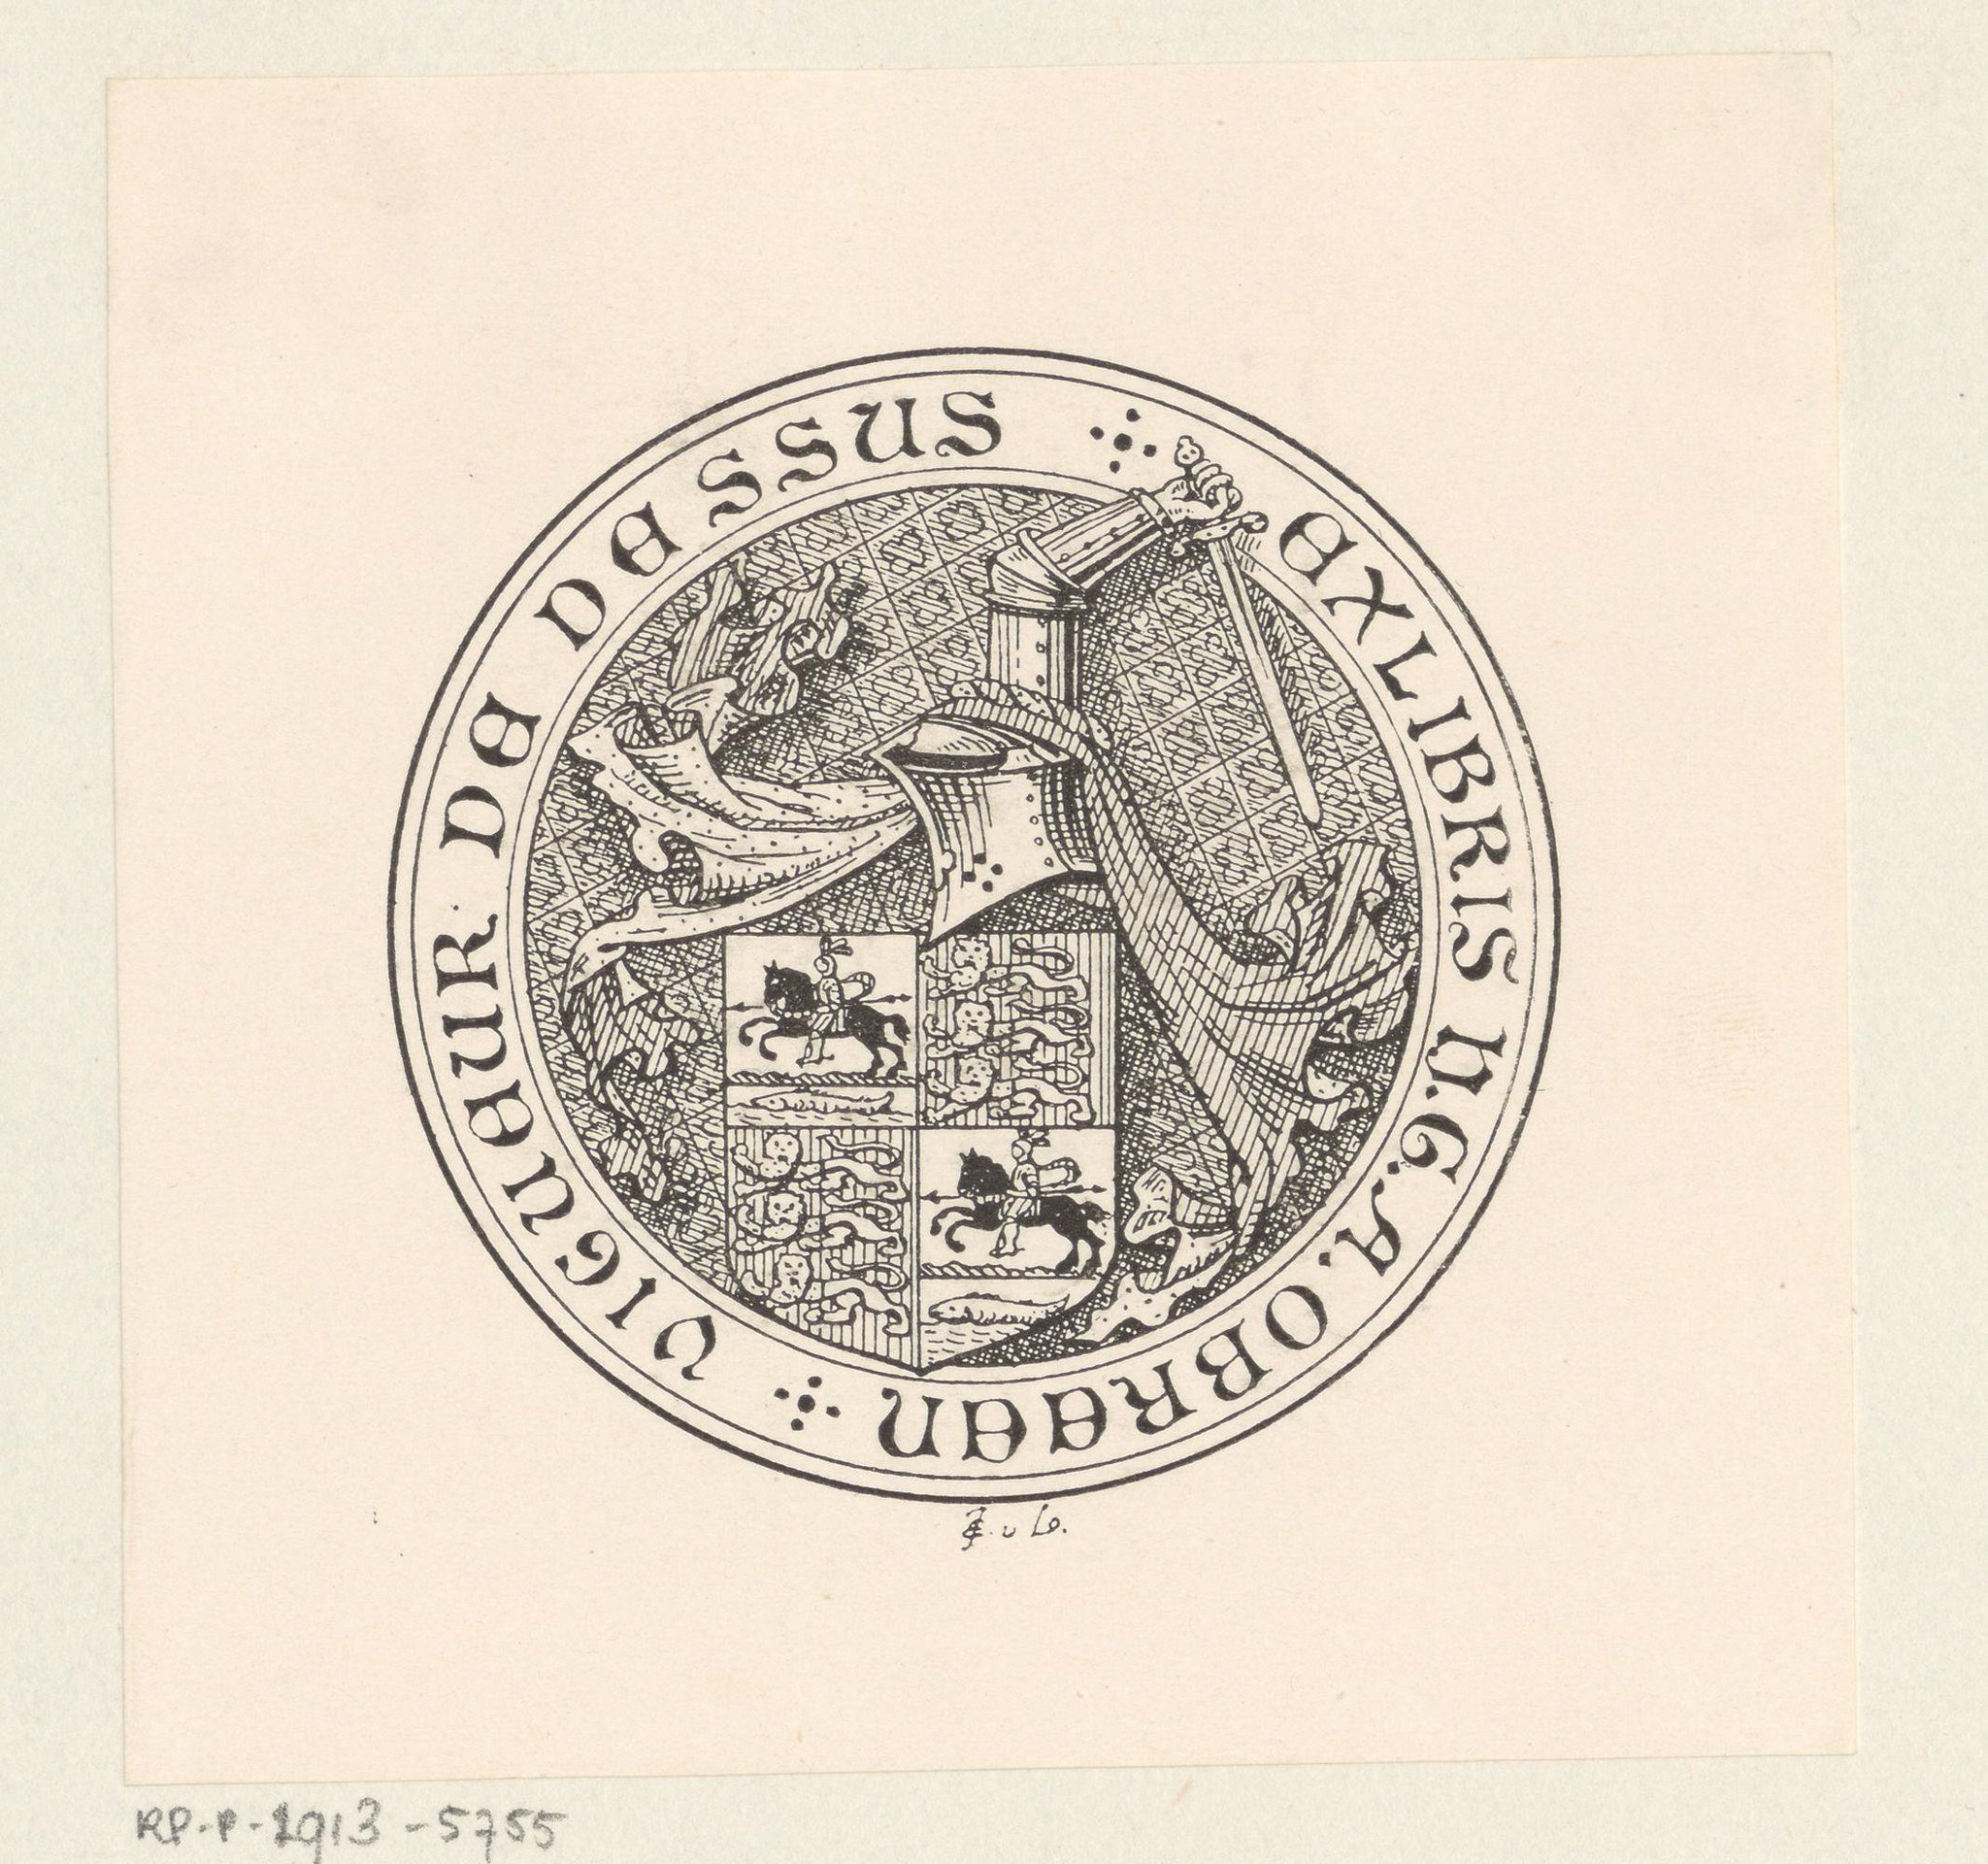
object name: bookplate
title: Ex libris van H.G.A. Obreen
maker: johannes evert van leeuwen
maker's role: painter, print maker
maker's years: 1855-1931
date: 1888-1913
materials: paper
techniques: printing block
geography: netherlands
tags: leiden, arm raised upward, armorial bearing, heraldry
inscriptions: collector's mark: Lugt 2233, collector's mark: Lugt 2760